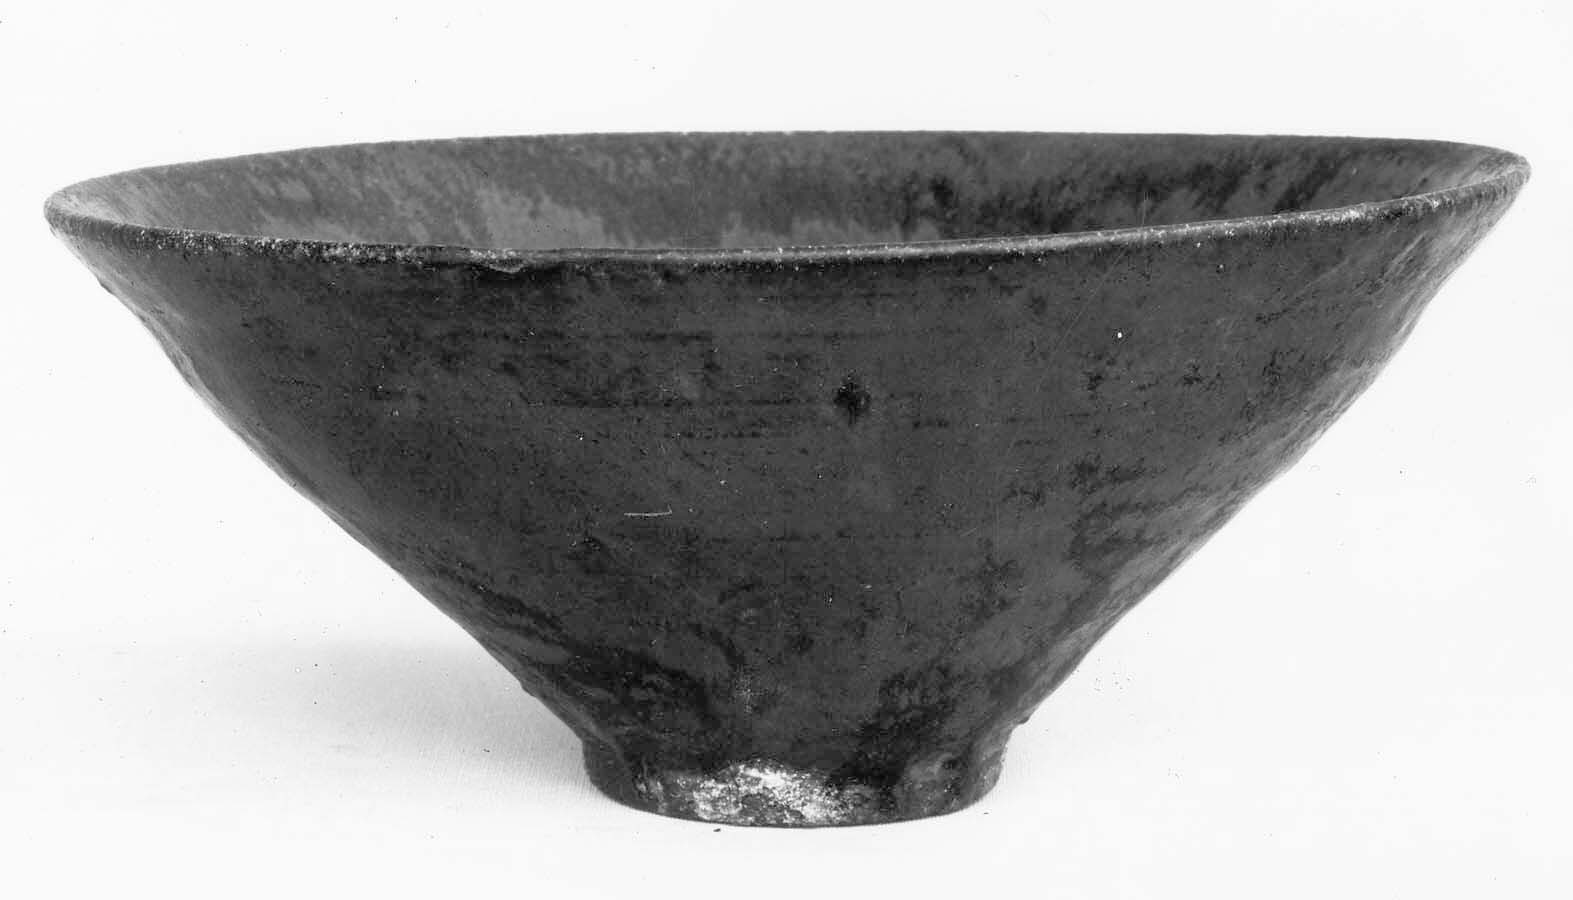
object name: bowl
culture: korean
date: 1001-1200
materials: glaze, iron, stoneware